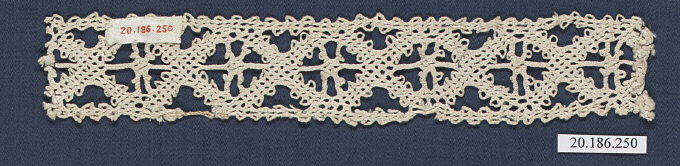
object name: insertion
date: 1501-1600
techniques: lace